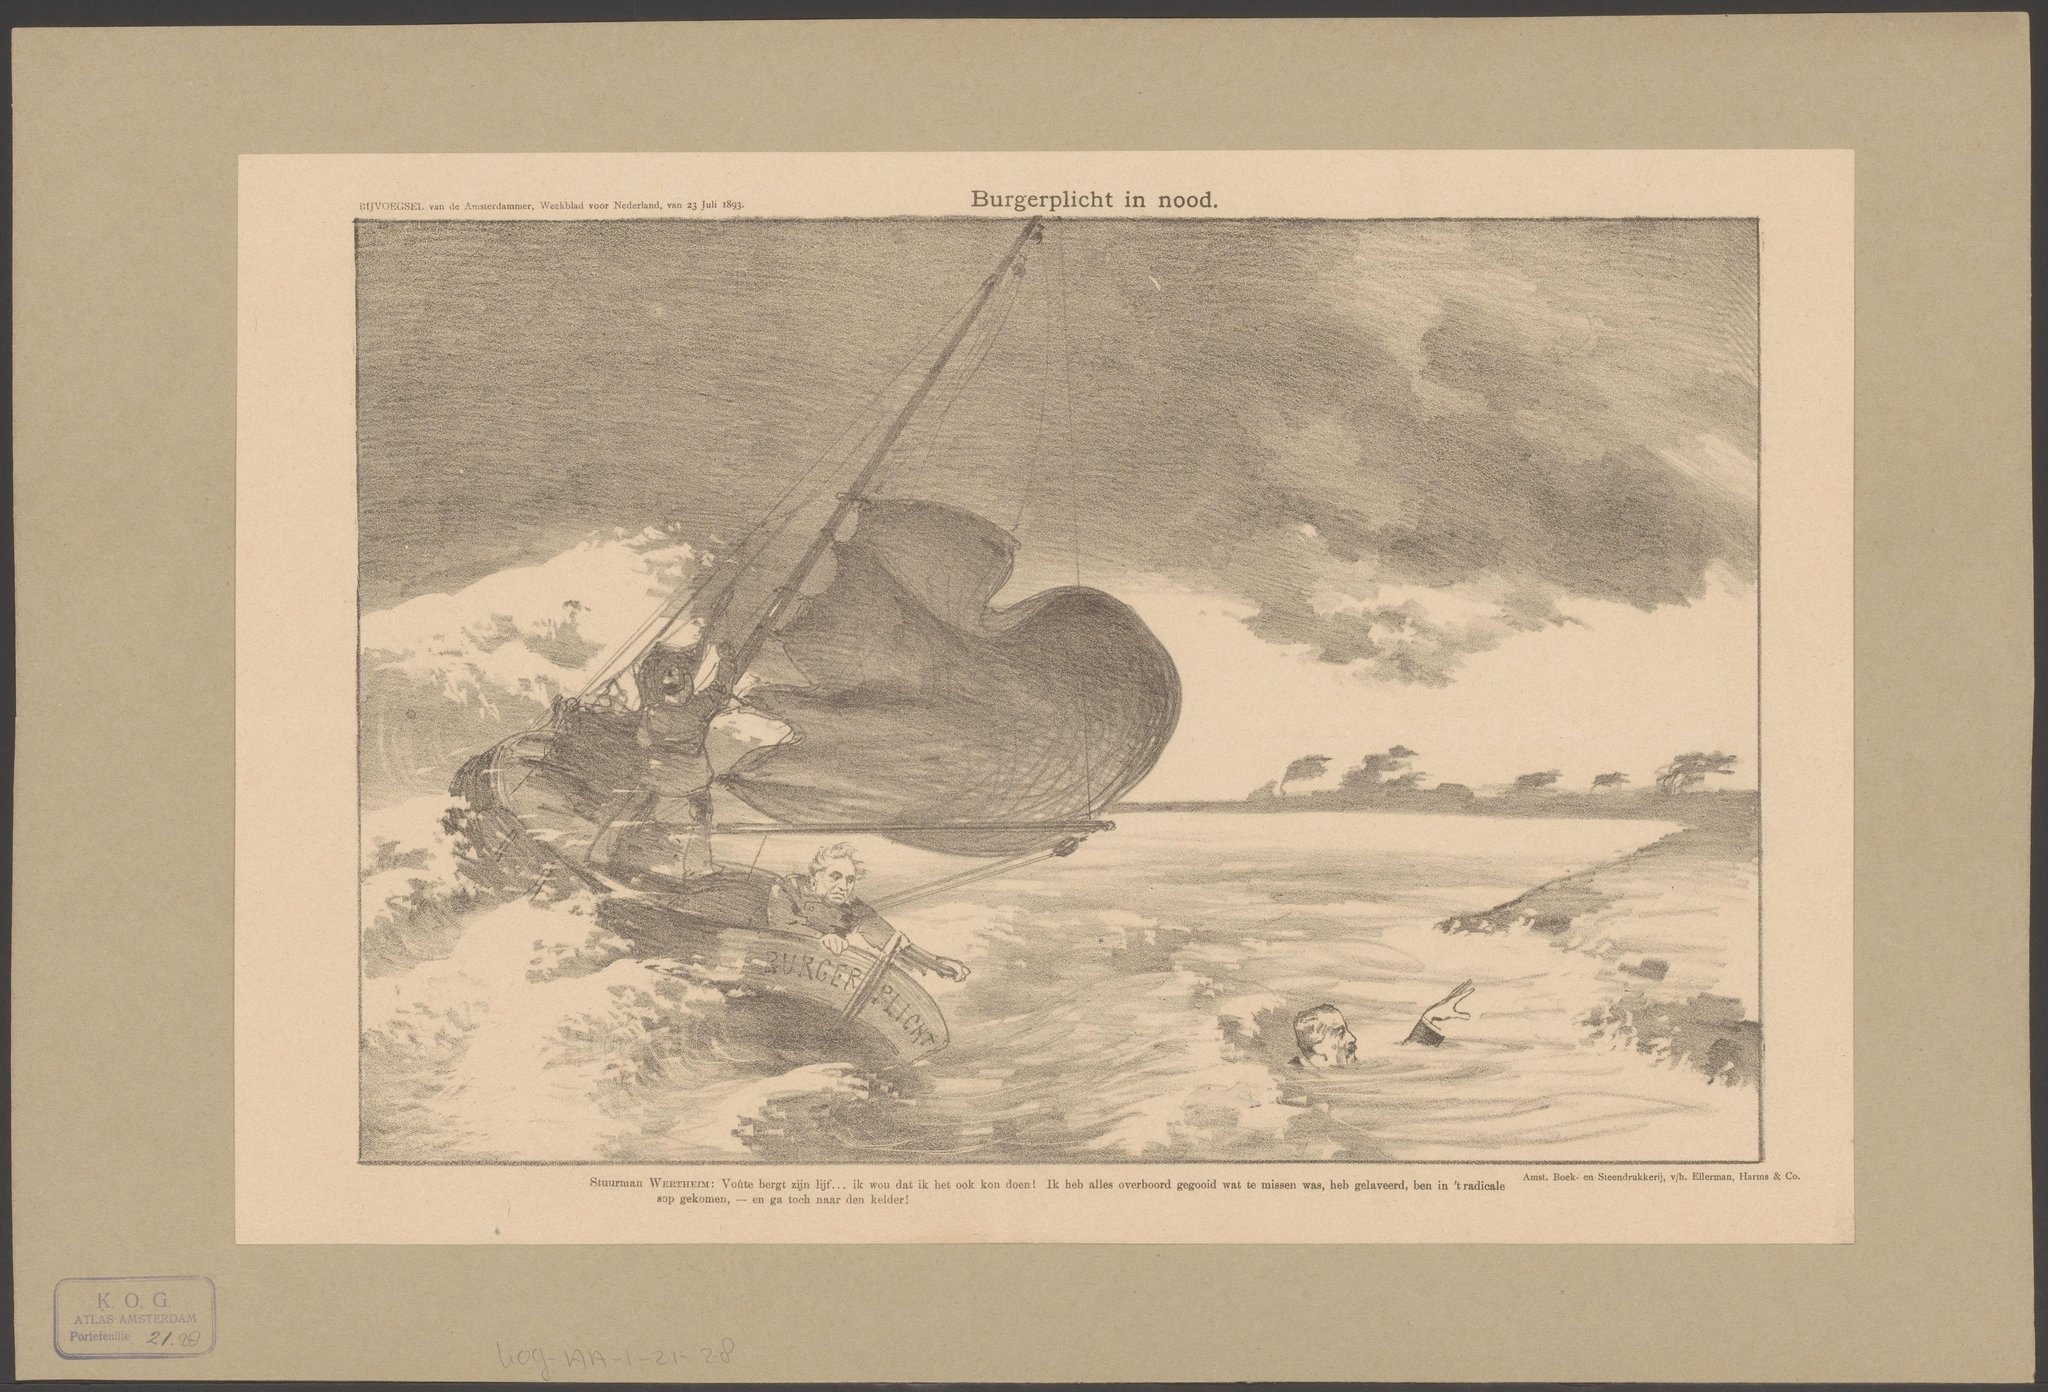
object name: cartoon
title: Burgerplicht in nood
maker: johan braakensiek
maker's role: draughtsman, print maker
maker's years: 1858-1940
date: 1893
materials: paper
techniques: letterpress printing, lithograph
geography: amsterdam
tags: amsterdam, politician, storm at sea, political caricatures and satires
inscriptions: collector's mark: Lugt 1641b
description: Abraham Carel Wertheim probeert als stuurman zijn schip 'Burgerplicht' nog te redden tijdens een storm op zee. Zijn helper Voûte is al van boord gesprongen en zwemt naar de kust. Onderwerpsrubriek binnen de Atlas Amsterdam: Kiesverenigingen, Politieke partijen.